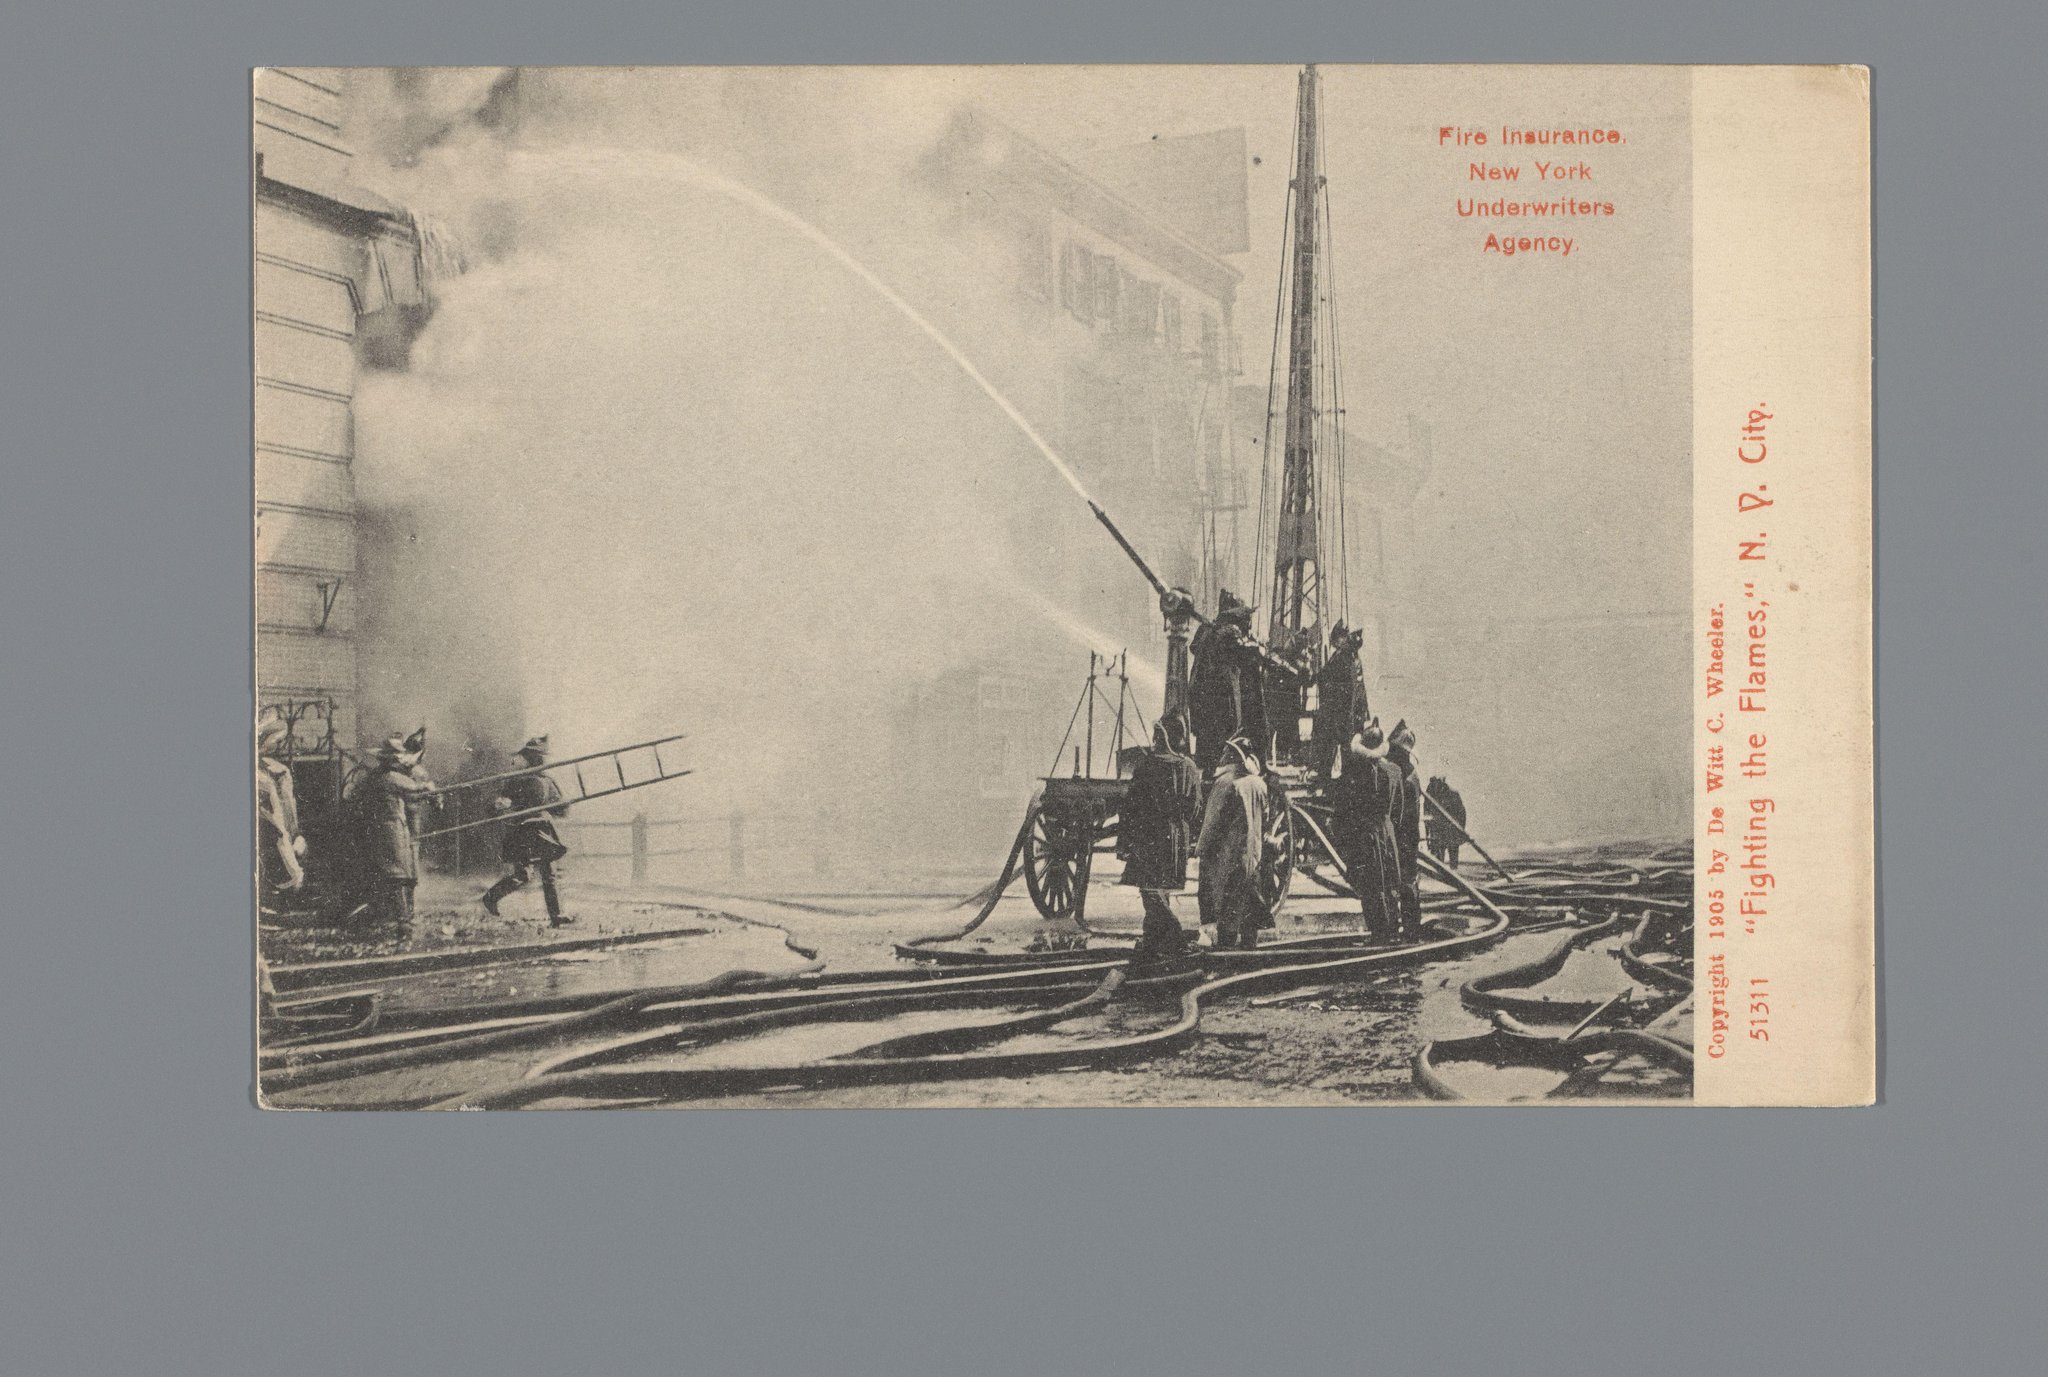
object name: ansichtkaart, prentbriefkaart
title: Reclame voor de Fire Insurance New York Underwriters Agency met een foto van het blussen van een brand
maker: dewitt c. wheeler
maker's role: fotograaf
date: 1905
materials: photographic support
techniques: photograph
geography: united states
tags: new york (city)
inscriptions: inscription: ‘The Rotograph Co., N.Y., City. (Germany.)’, inscription: ‘Fire Insurance / New York / Underwriters / Agency’, inscription: ‘Copyright 1905 by De Witt C. Wheeler / 51311 “Fighting the Flames,”, N Y, City.’